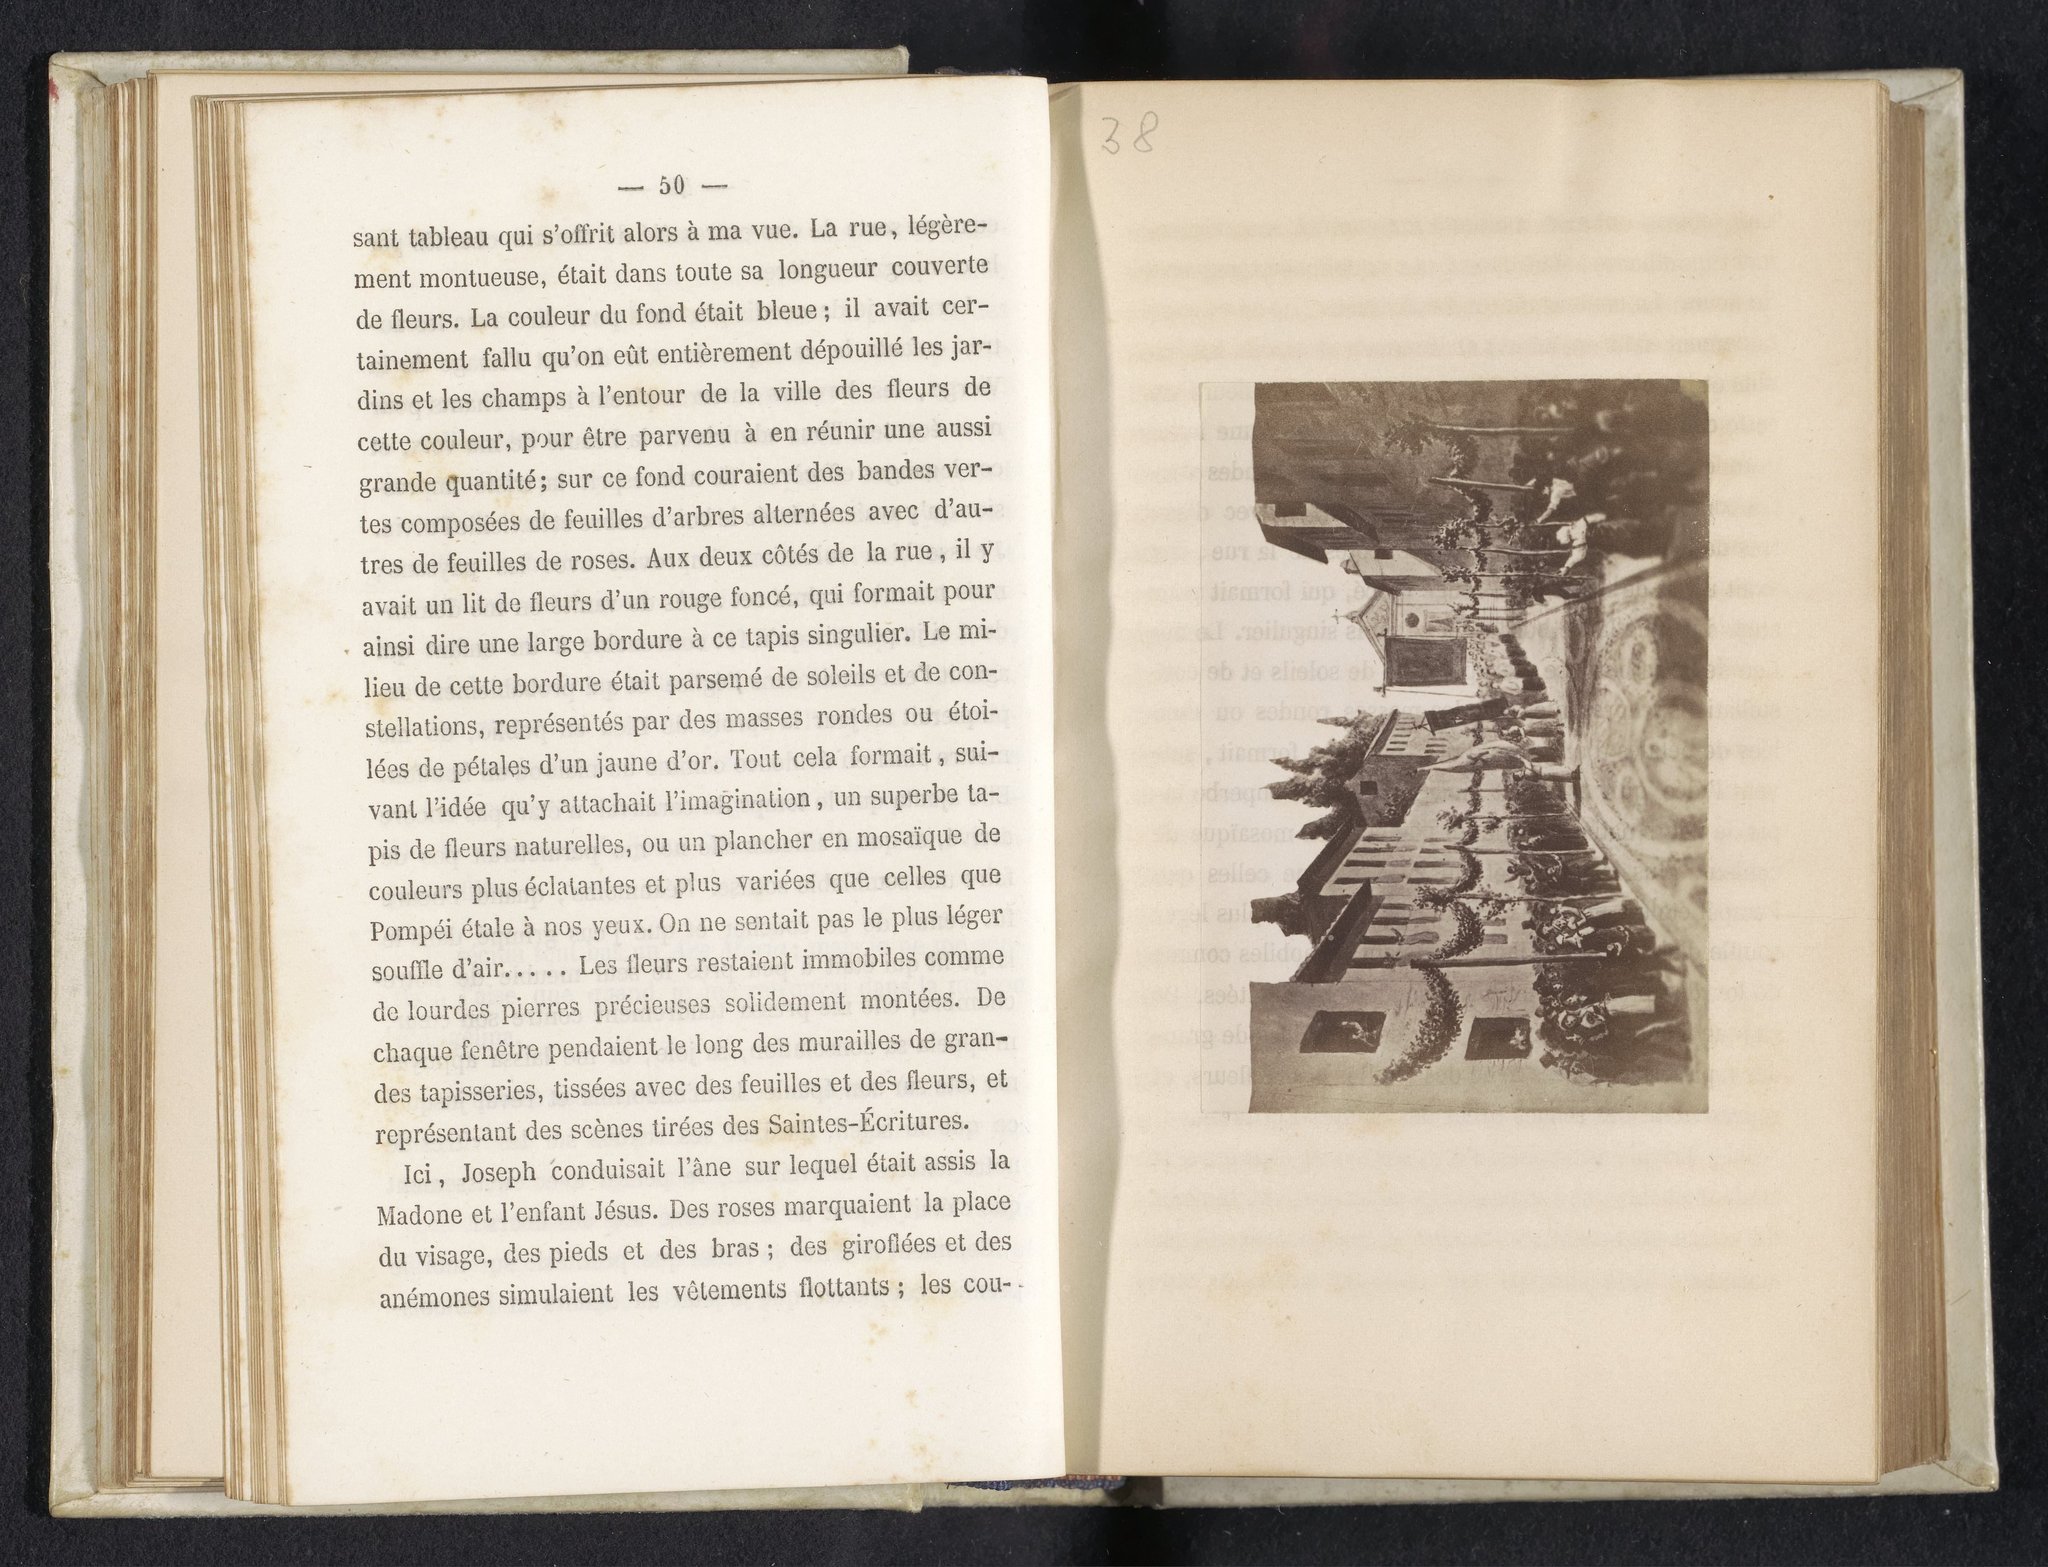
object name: photograph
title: Fotoreproductie van een schilderij, voorstellende een processie in een straat (vermoedelijk) te Italië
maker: Anonymous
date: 1850-1860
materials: photographic support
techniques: albumen print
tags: procession ~ christian religion, street